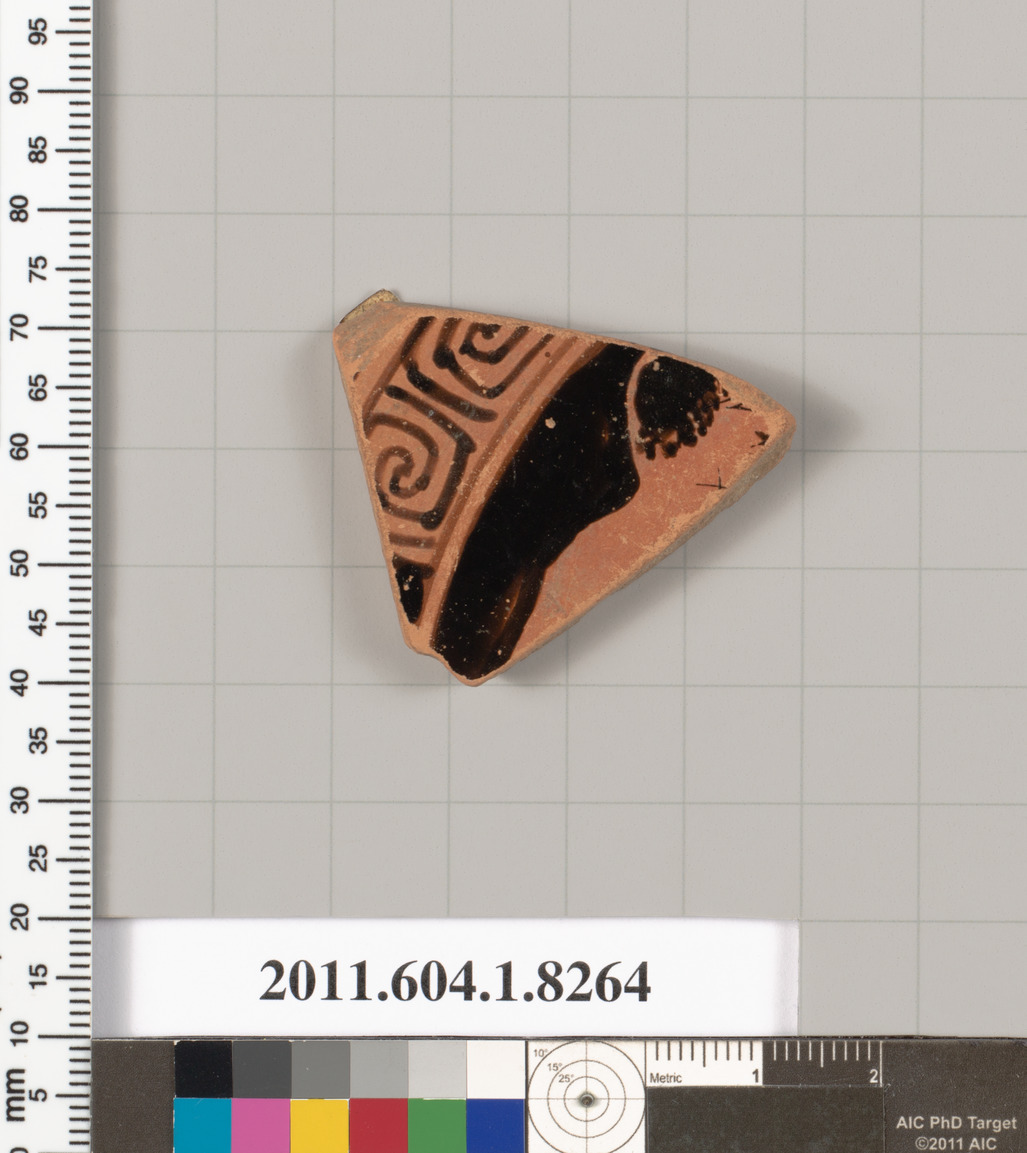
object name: kylix fragment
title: Terracotta fragment of a kylix (drinking cup)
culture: greek, attic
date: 410-400 BCE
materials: terracotta